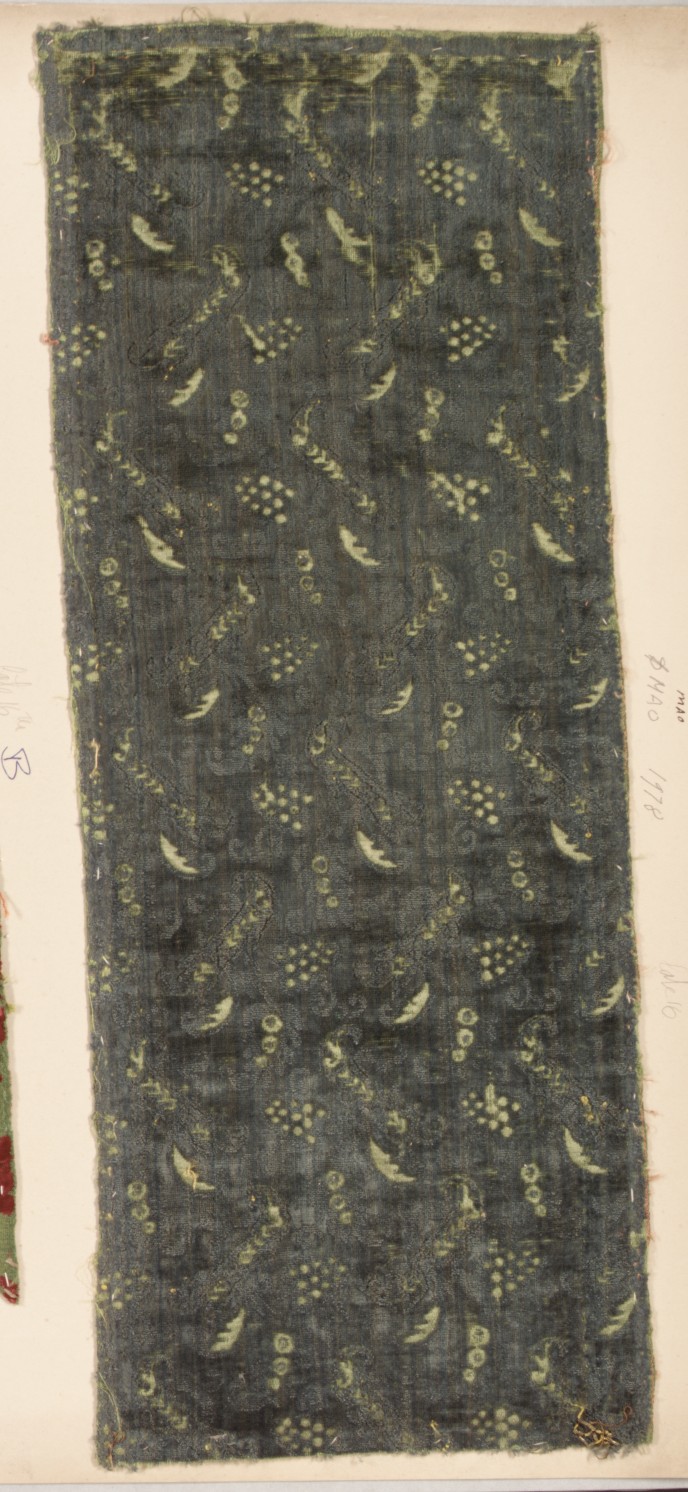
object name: fragment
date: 1567-1600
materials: silk